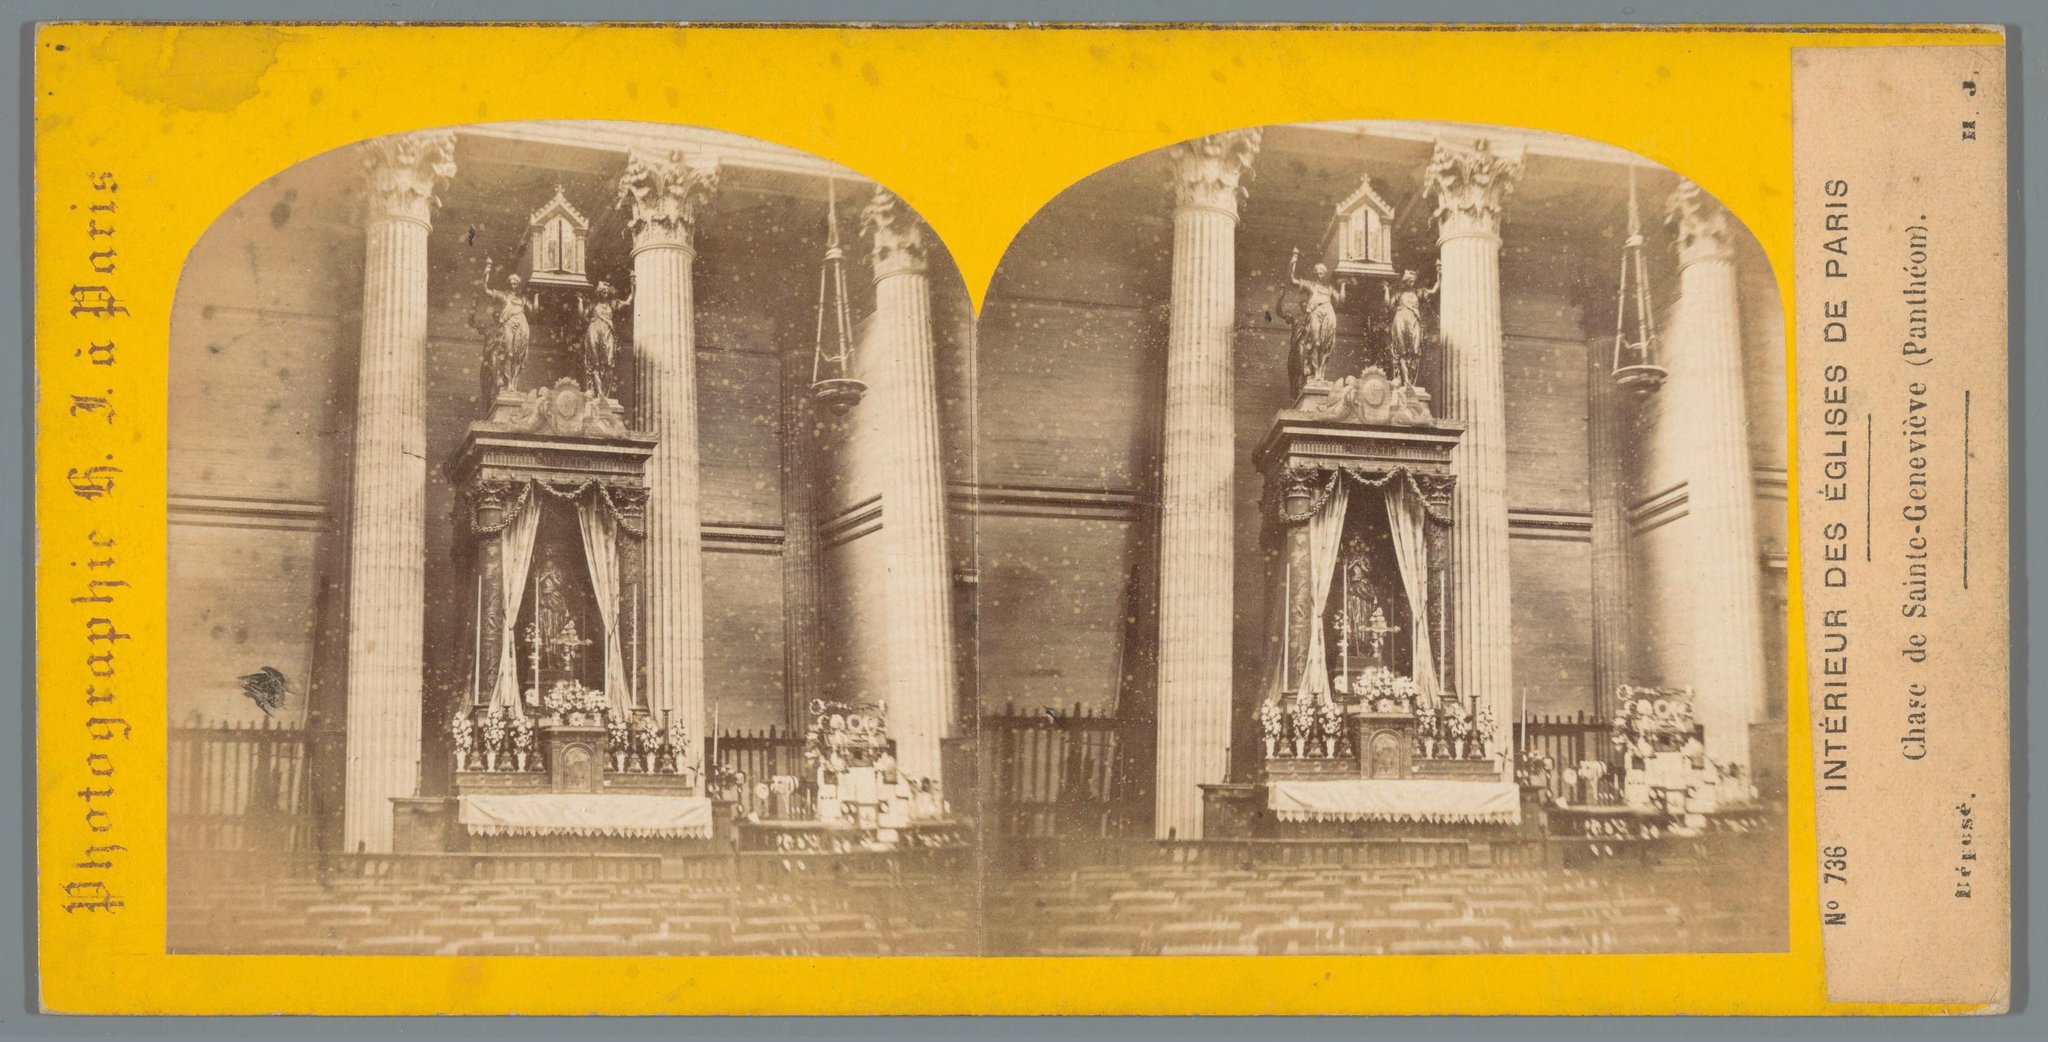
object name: stereograph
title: Intérieur des Églises de Paris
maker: hippolyte jouvin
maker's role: fotograaf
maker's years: 1825-1889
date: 1850-1880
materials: cardboard, photographic support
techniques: albumen print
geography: pantheon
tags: parts of church interior: chapel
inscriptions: number: ‘No 736’